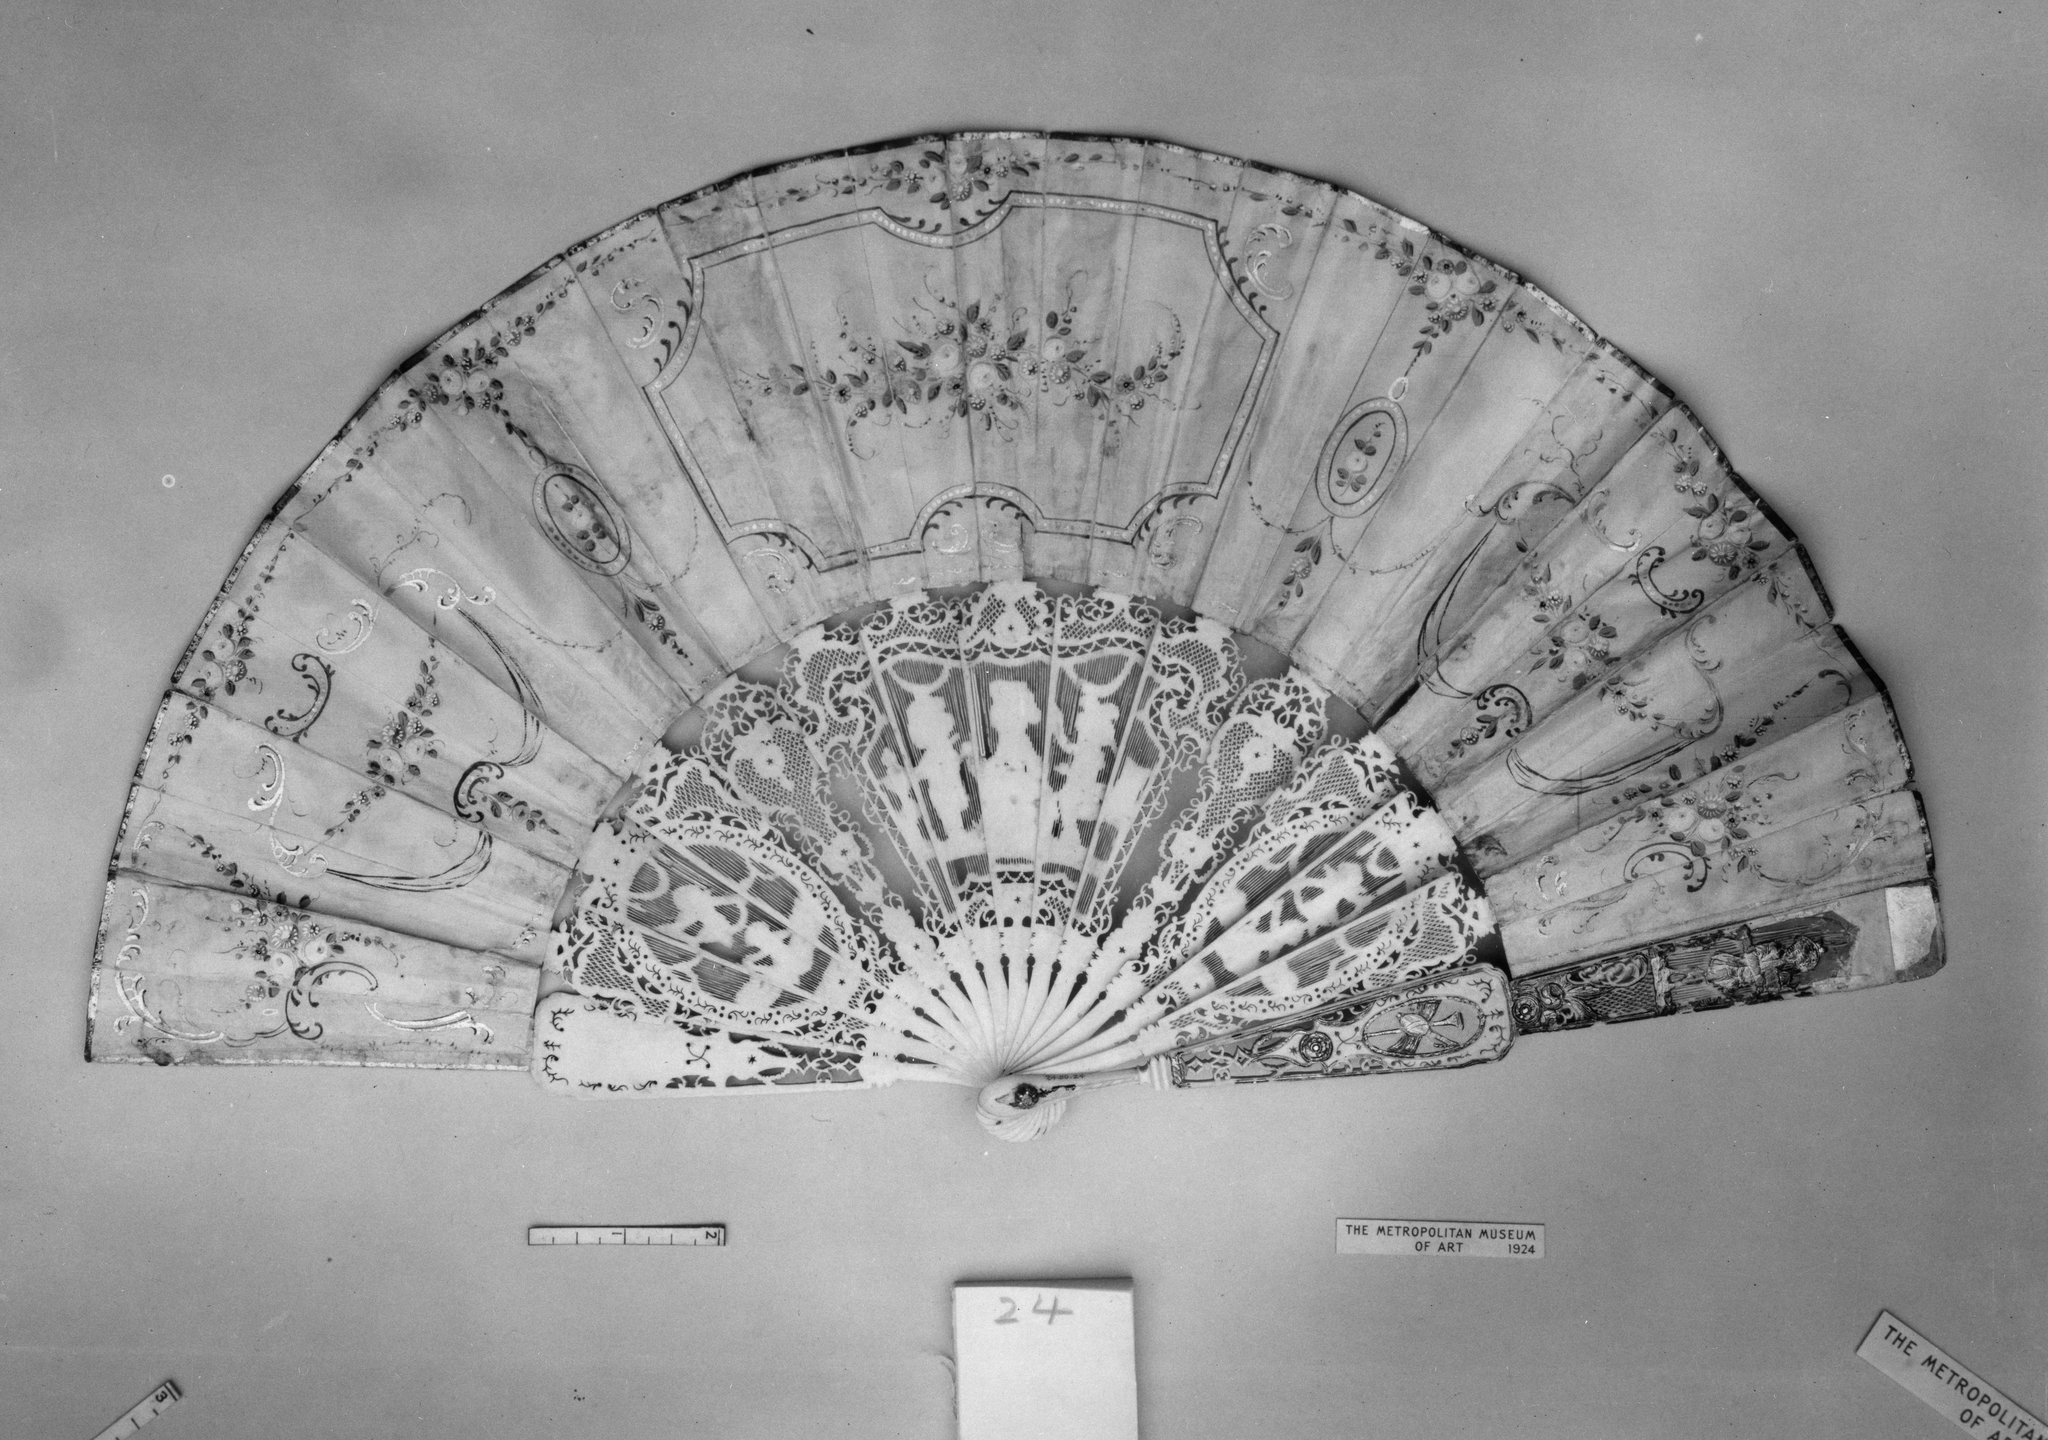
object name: fan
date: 1785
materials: ivory, silk